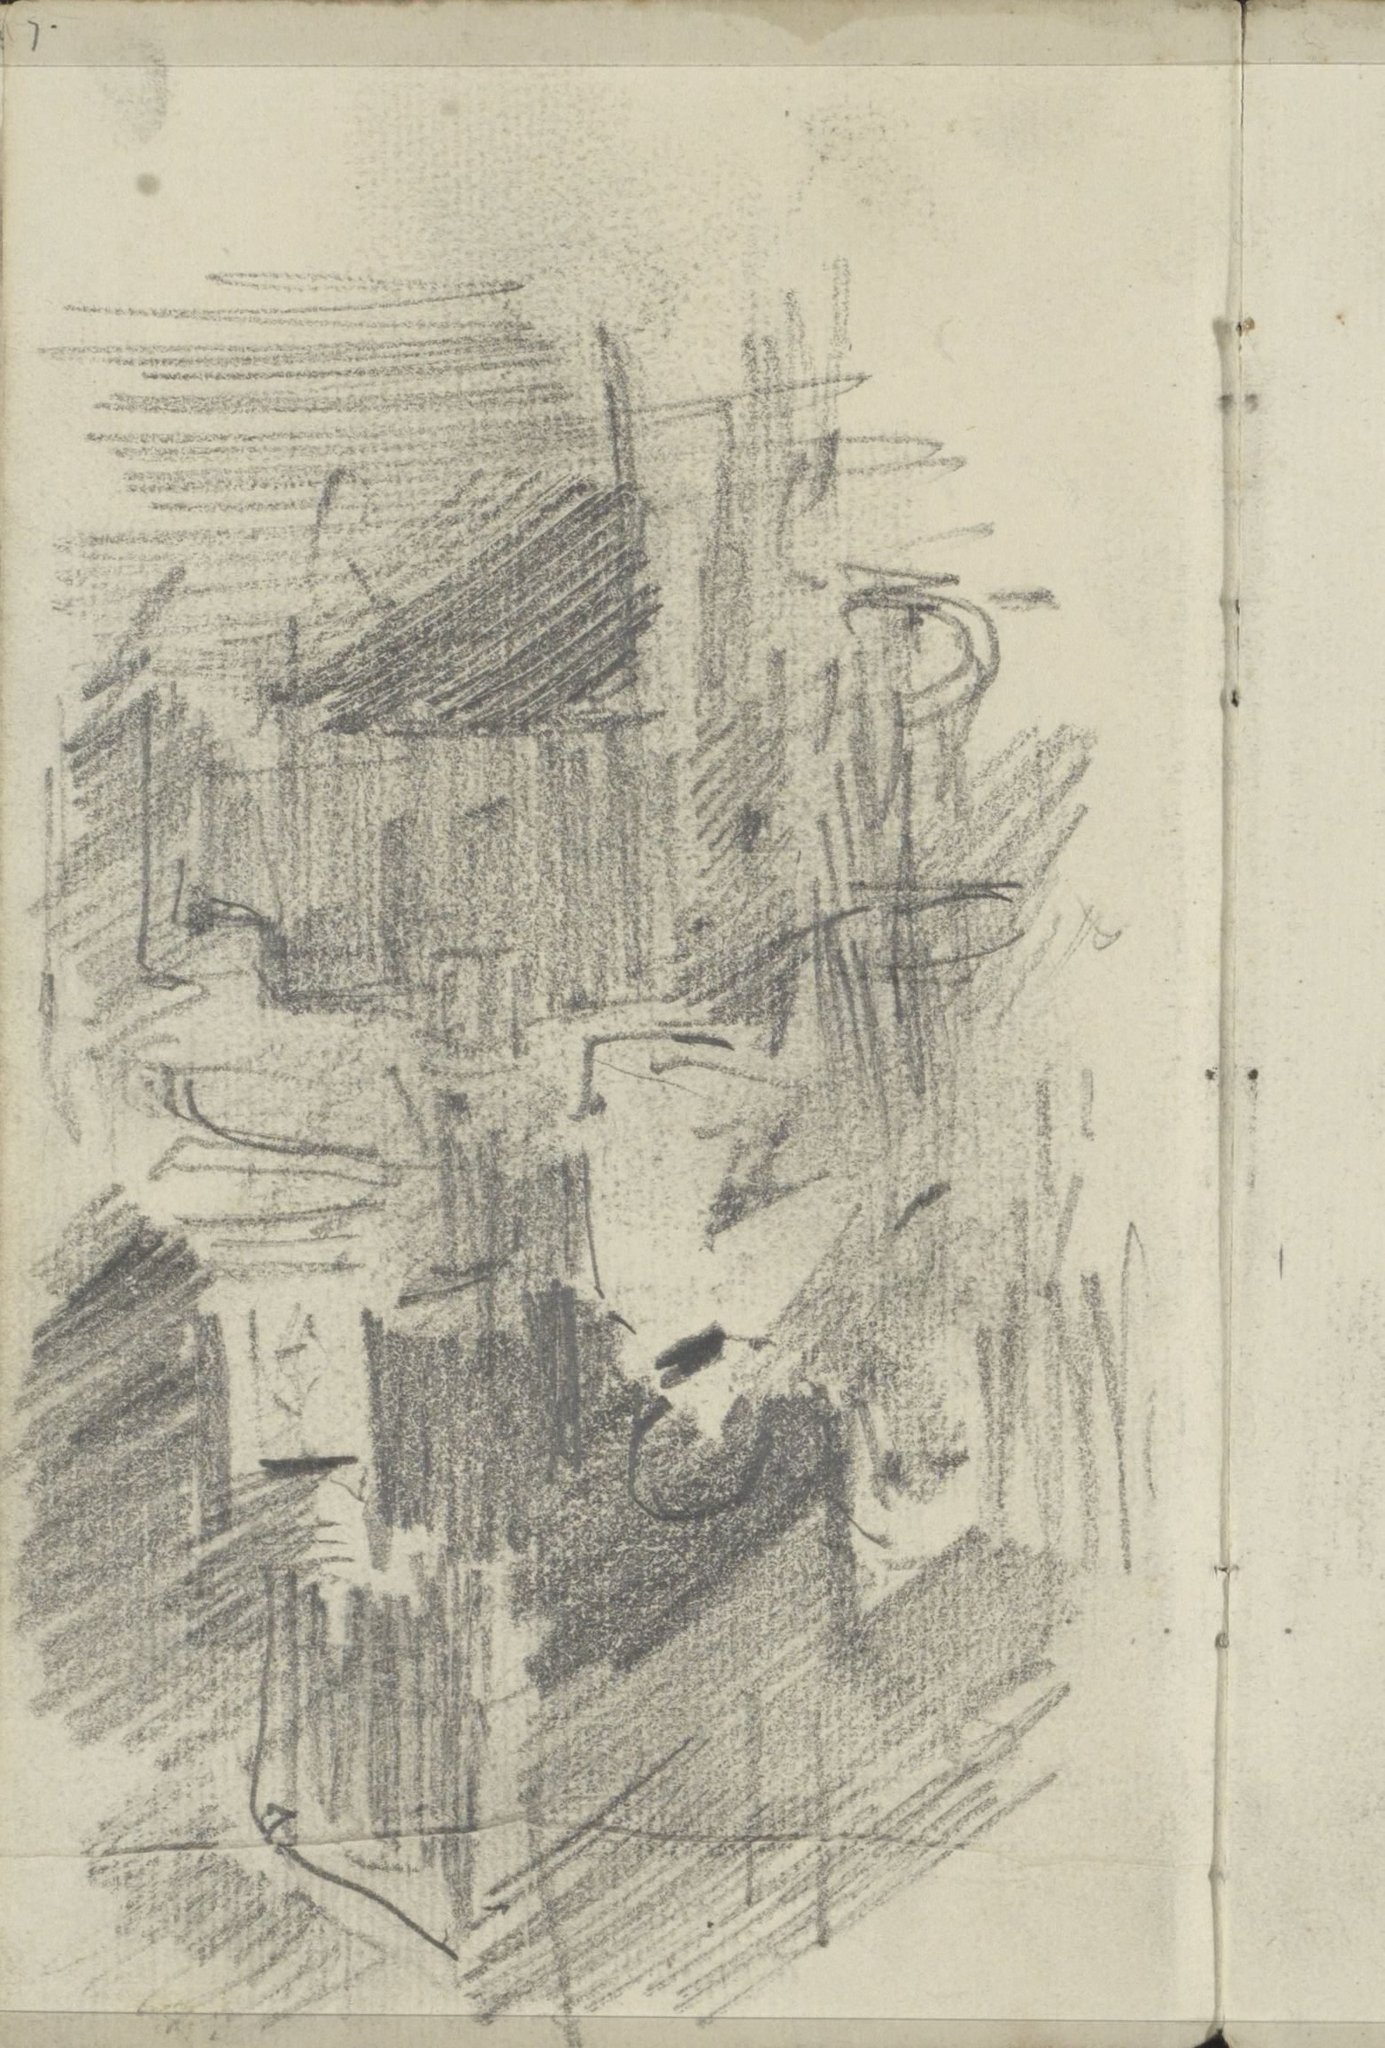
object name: sketchbook leaf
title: Zittende figuur in een interieur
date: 1882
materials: paper, pencil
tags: sitting figure, interior ~ representation of a building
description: Pagina 7 uit een schetsboek met 31 bladen vervaardigd te Den Haag en Rotterdam.